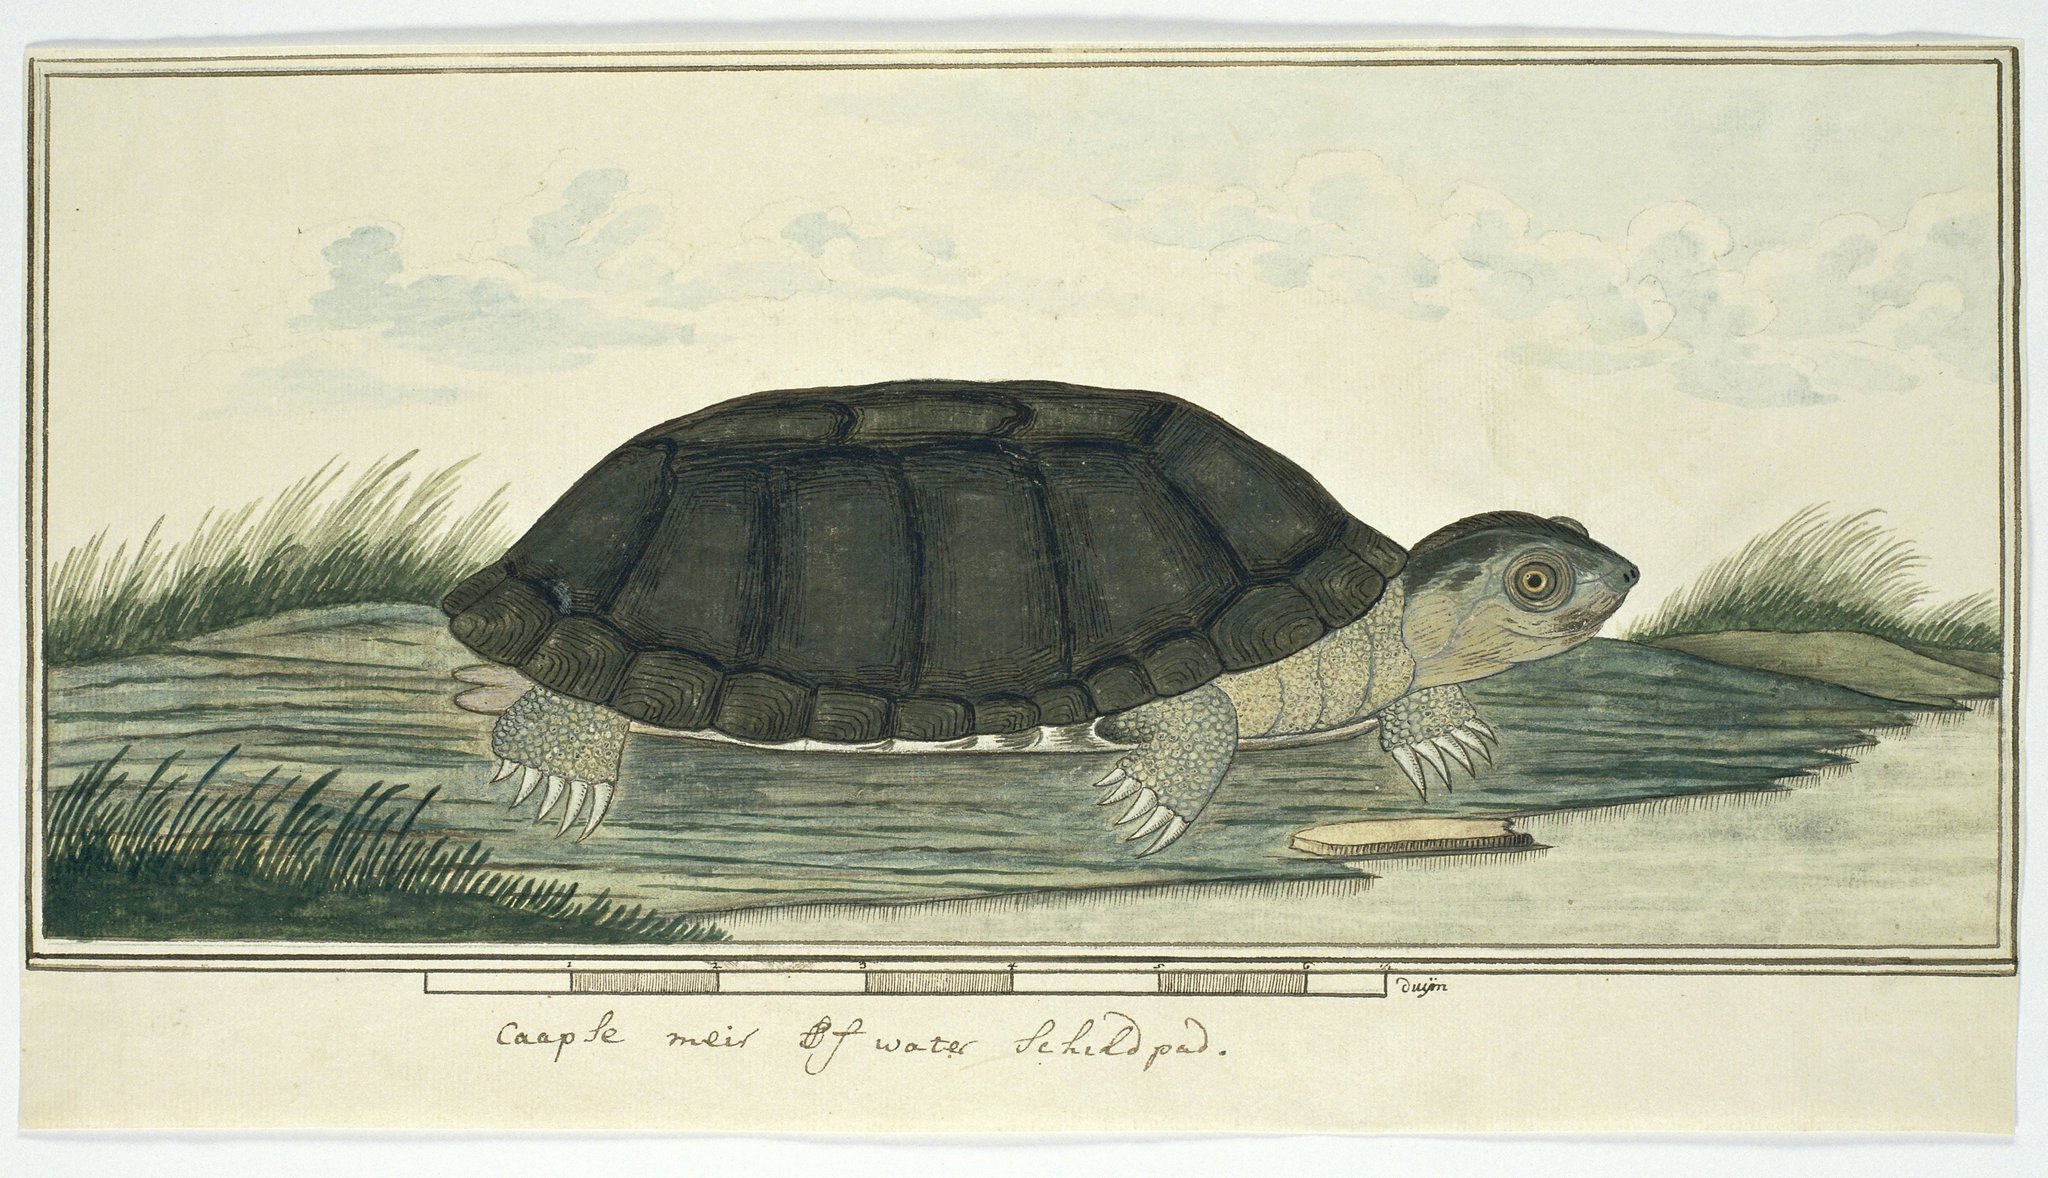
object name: dierstudie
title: Pelomedusa subrufa (African helmeted turtle)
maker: robert jacob gordon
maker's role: draughtsman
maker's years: 1743-1795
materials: chalk, paint, ink, paper, pencil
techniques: brush, pen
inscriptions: annotation: ‘Caapse meir of water Schildpad’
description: Slangehalsschildpad (Pelomedusa subrufa); met een schaalverdeling in duim onder de kaderlijnen onderaan de voorstelling.